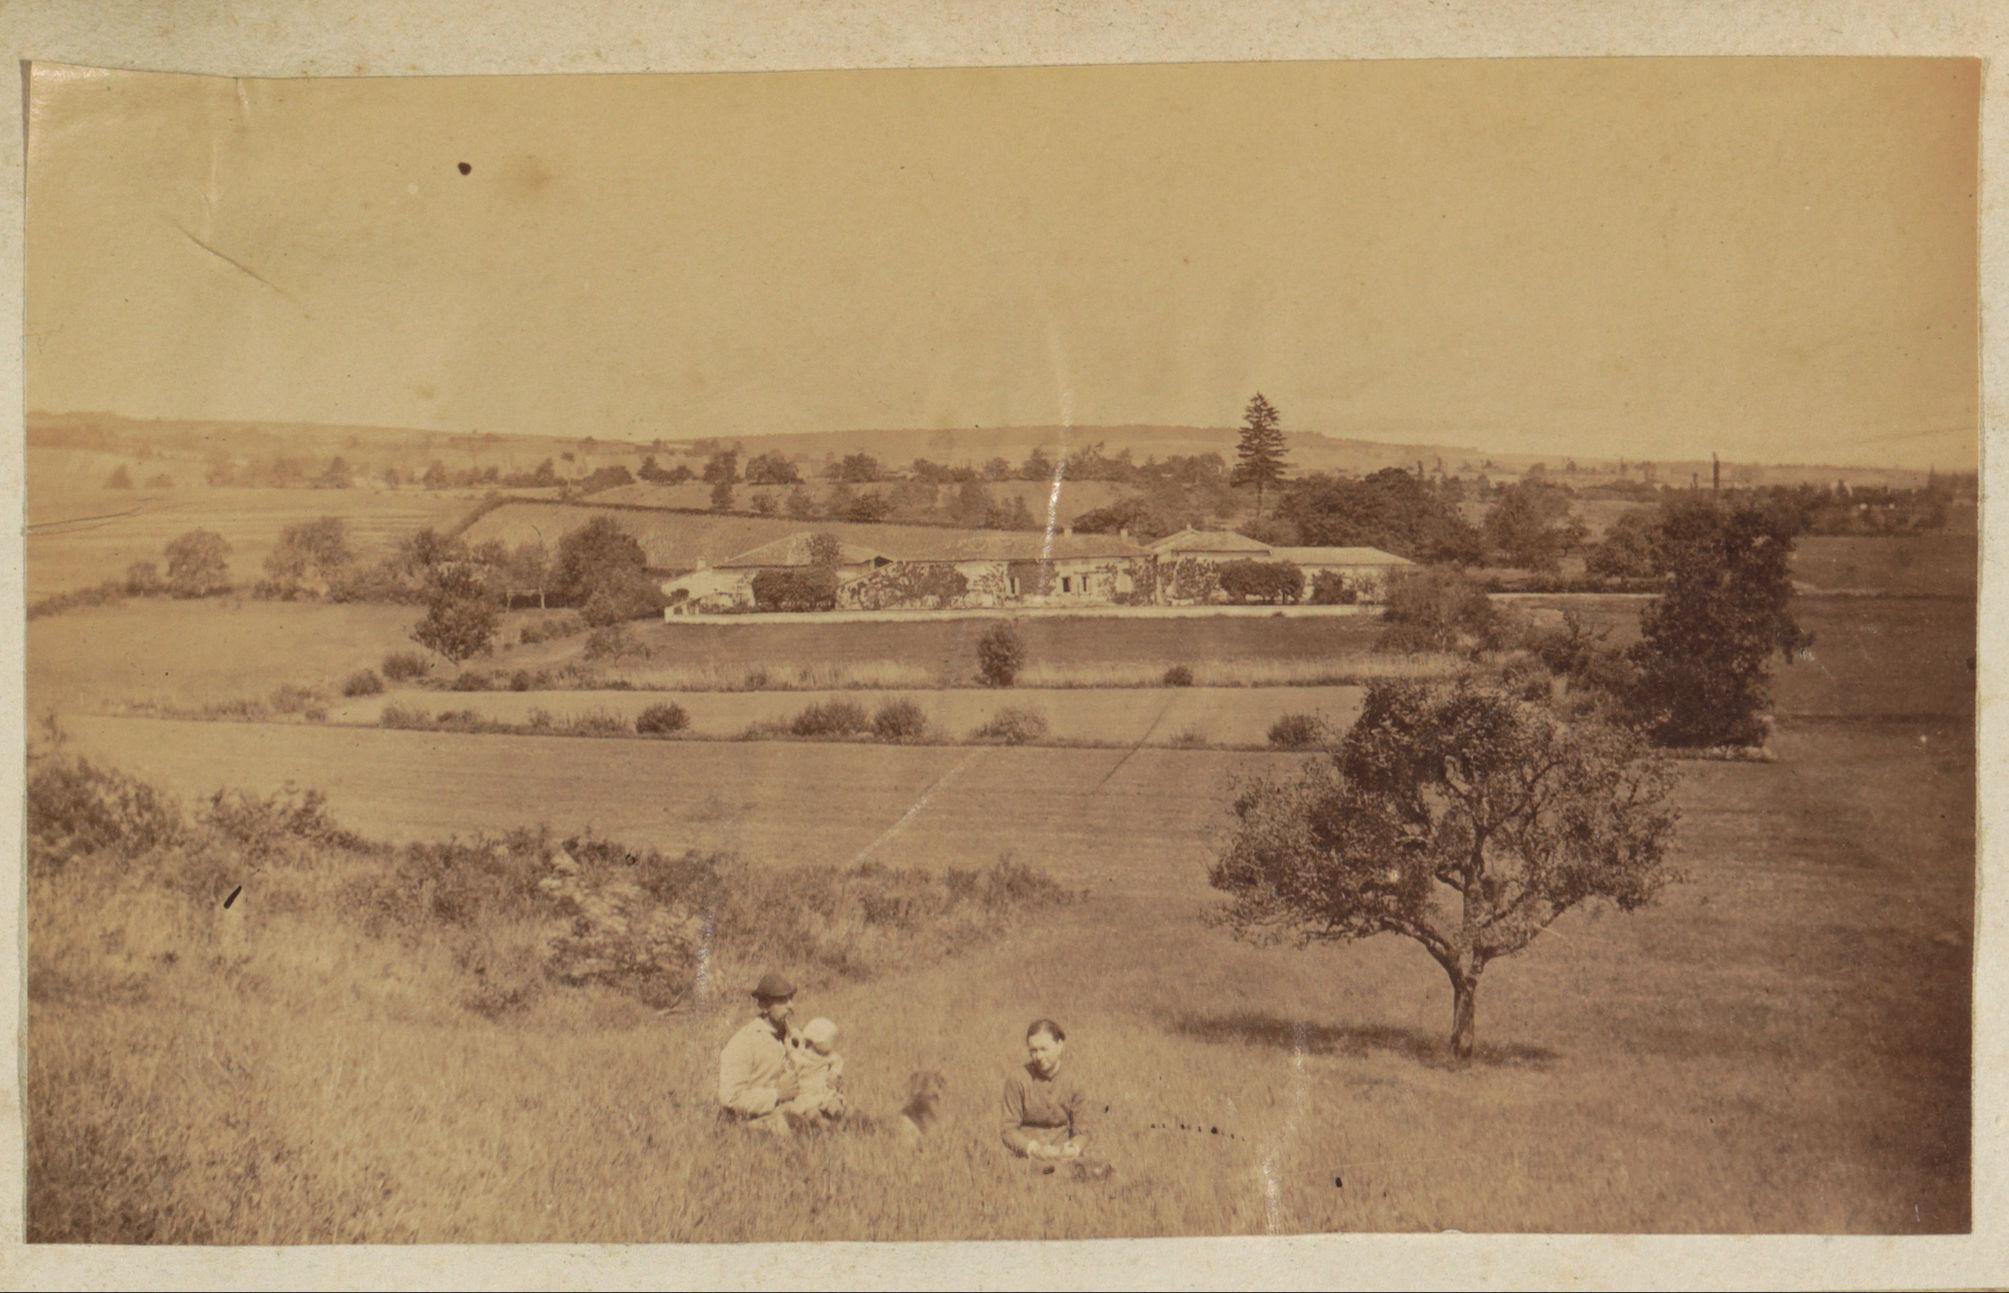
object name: photograph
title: Landschap in Frankrijk met op de voorgrond een stel met een kind zittend in het gras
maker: Anonymous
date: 1805-1884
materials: photographic support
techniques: albumen print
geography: france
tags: family group, especially parents with their child(ren), landscapes in tropical and sub-tropical regions, france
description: Onderdeel van Album van een Franse amateurfotograaf met opnames van familie, militairen, industrie, landschappen en bezienswaardigheden in Frankrijk.